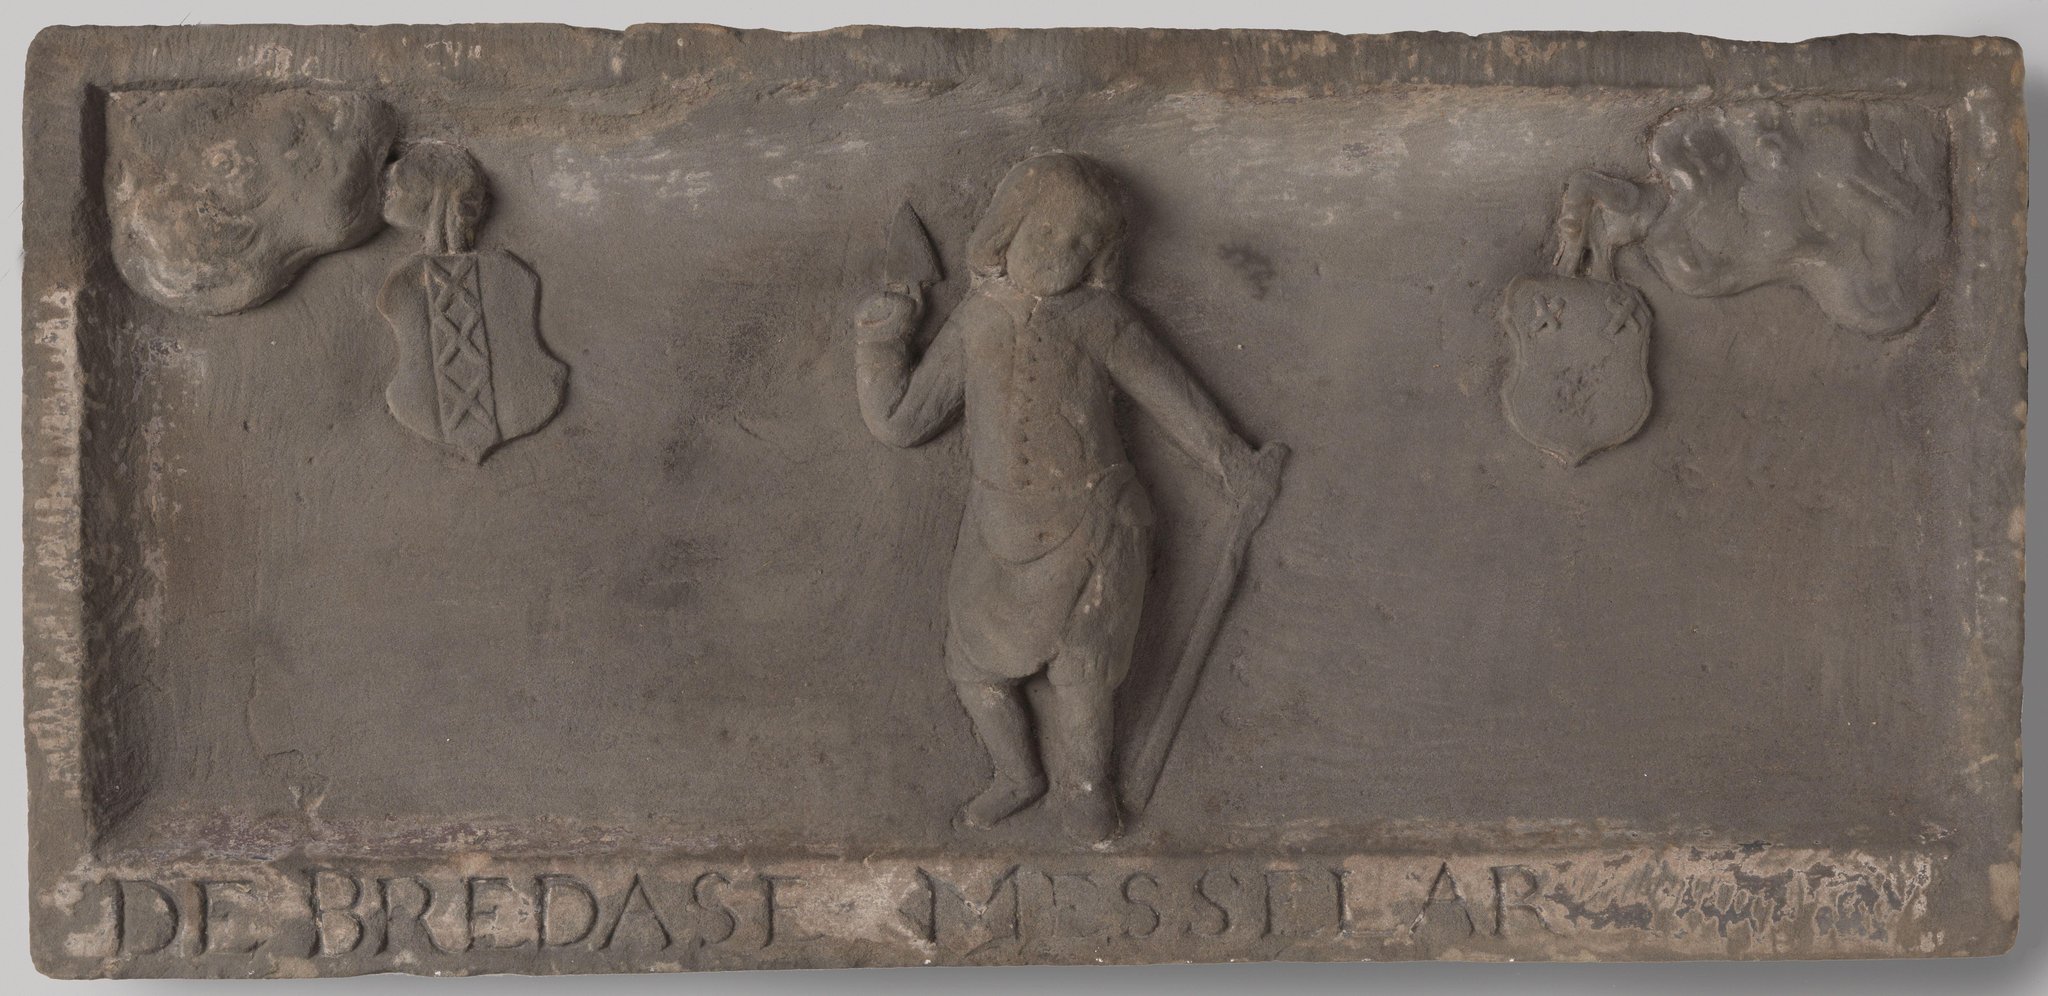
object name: gable stone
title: Gevelsteen met man ten voeten uit, met links en rechts van hem een wapen, en daaronder de tekst De Bredase Messelar[...]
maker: Anonymous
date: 1400-1950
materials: stone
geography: netherlands